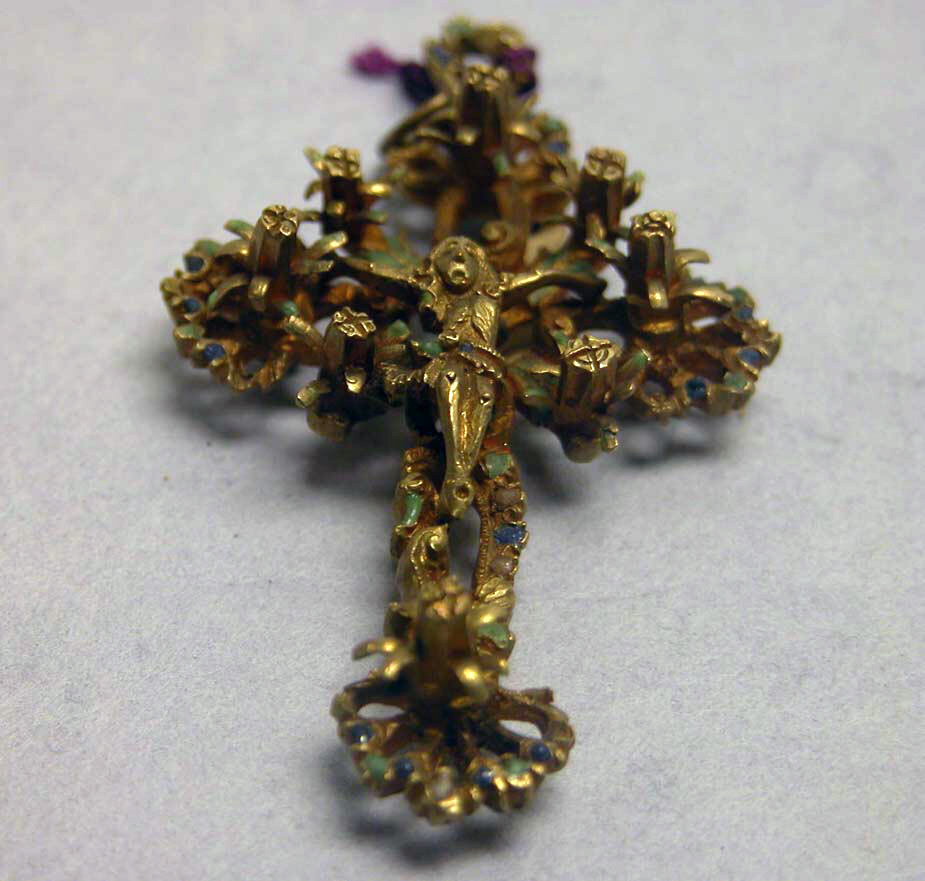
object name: pendant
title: Crucifix Pendant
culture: filipino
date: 1601-1800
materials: enamel, gold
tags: christ,crucifixion